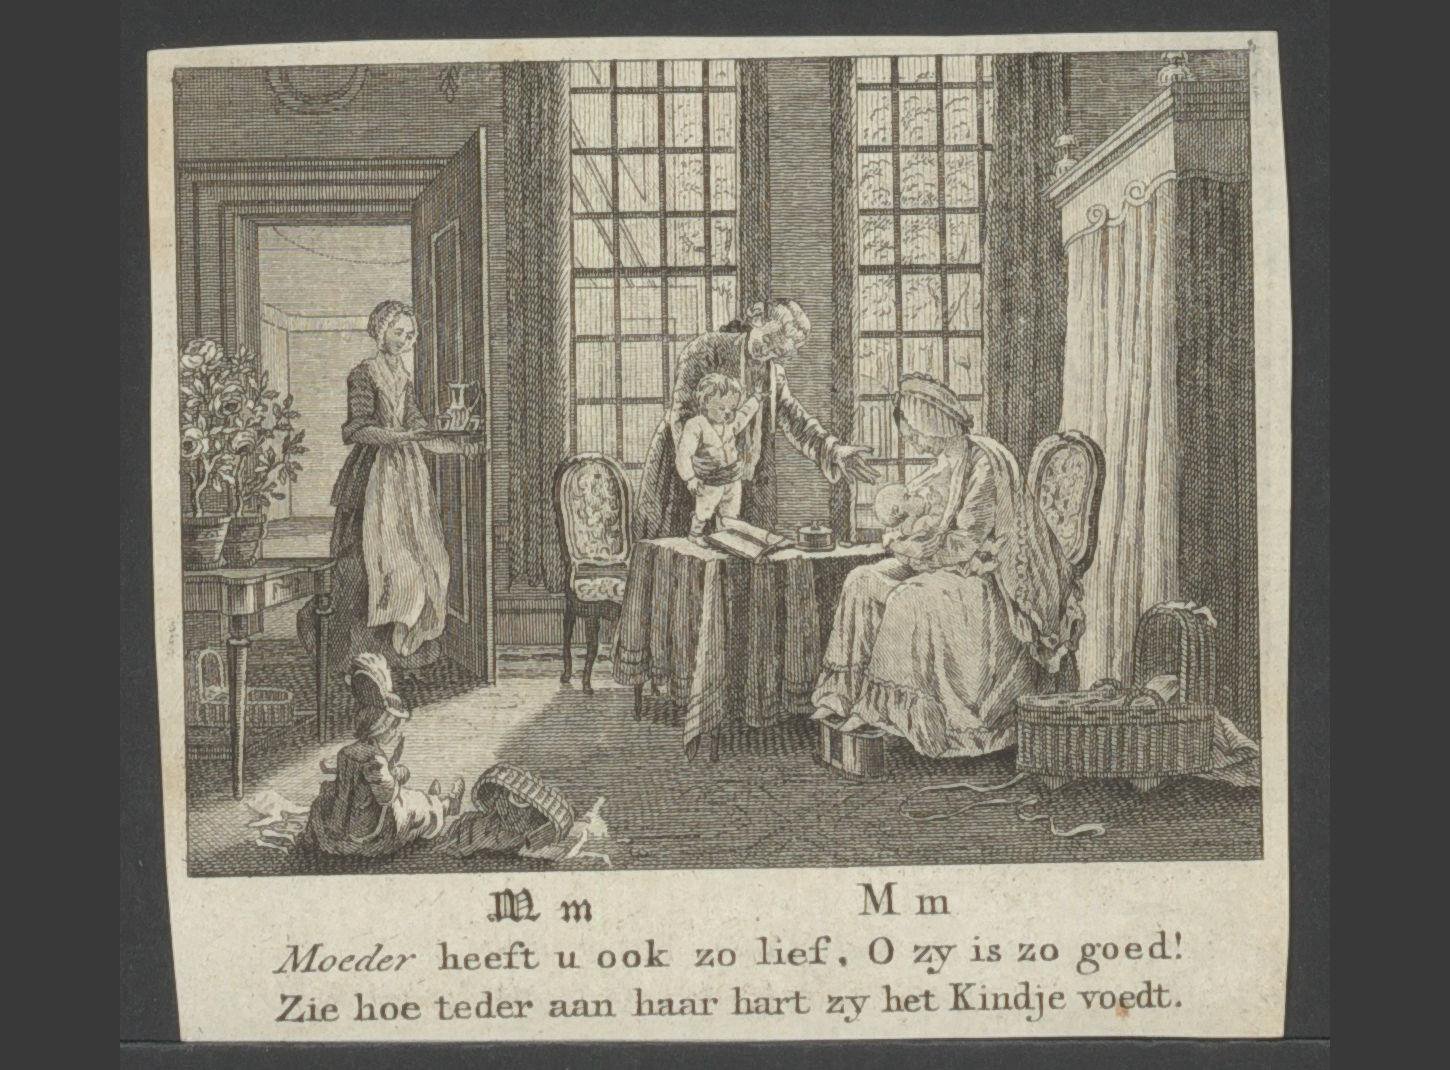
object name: print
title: Moeder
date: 1781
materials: paper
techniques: engraving, etching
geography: amsterdam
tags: father with son(s) and daughter(s) (father-love), letters, alphabet, script, feeding a baby, mother and baby or young child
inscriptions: collector's mark: Lugt 1641, stamp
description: Gezin in een kamer, een moeder voedt haar kind. De vader zet een kind op de tafel. Linksonder speelt een kind. Onder de voorstelling de letter M in twee verschillende lettertypes. Onderaan een tweeregelig vers over de moeder. Onderwerpsrubrieken binnen de Atlas Zeden en Gewoonten: Onderwijs en Wetenschappen, Opvoeding en Onderwijs, Haneboeken en schoolprenten.